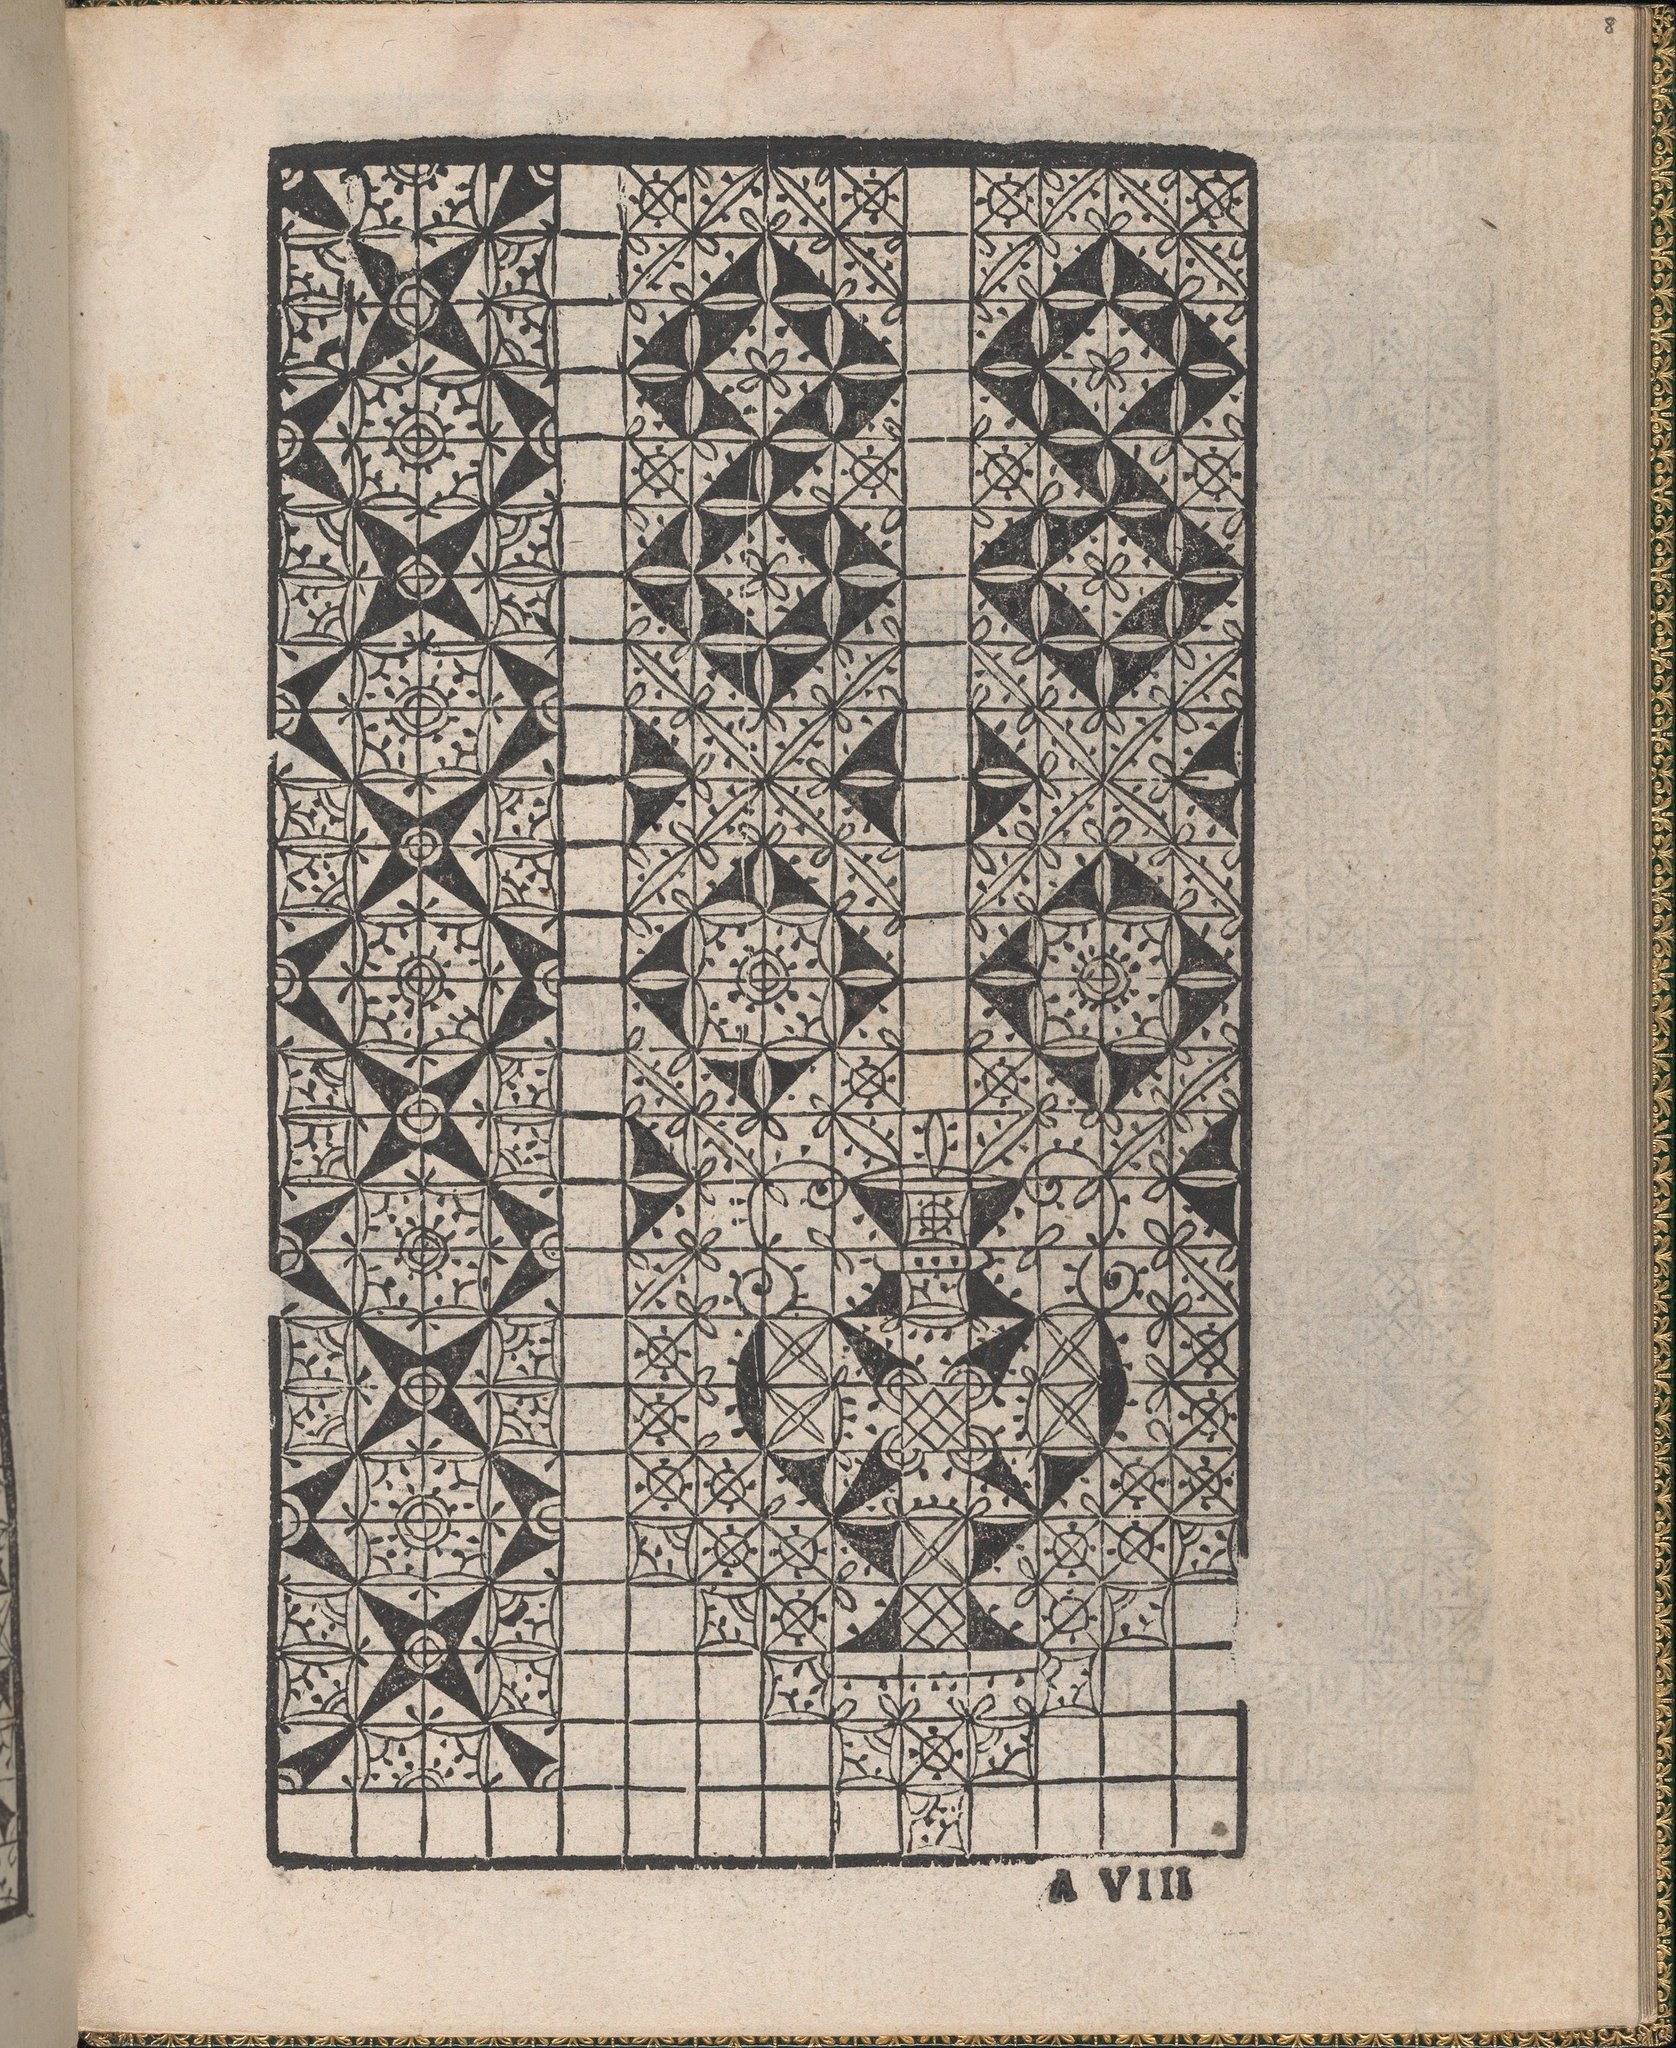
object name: book print ornament architecture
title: Ornamento delle belle & virtuose donne, page 5 (recto)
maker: matteo pagano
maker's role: publisher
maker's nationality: italian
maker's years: 1515-1588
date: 1554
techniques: woodcut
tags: ornament